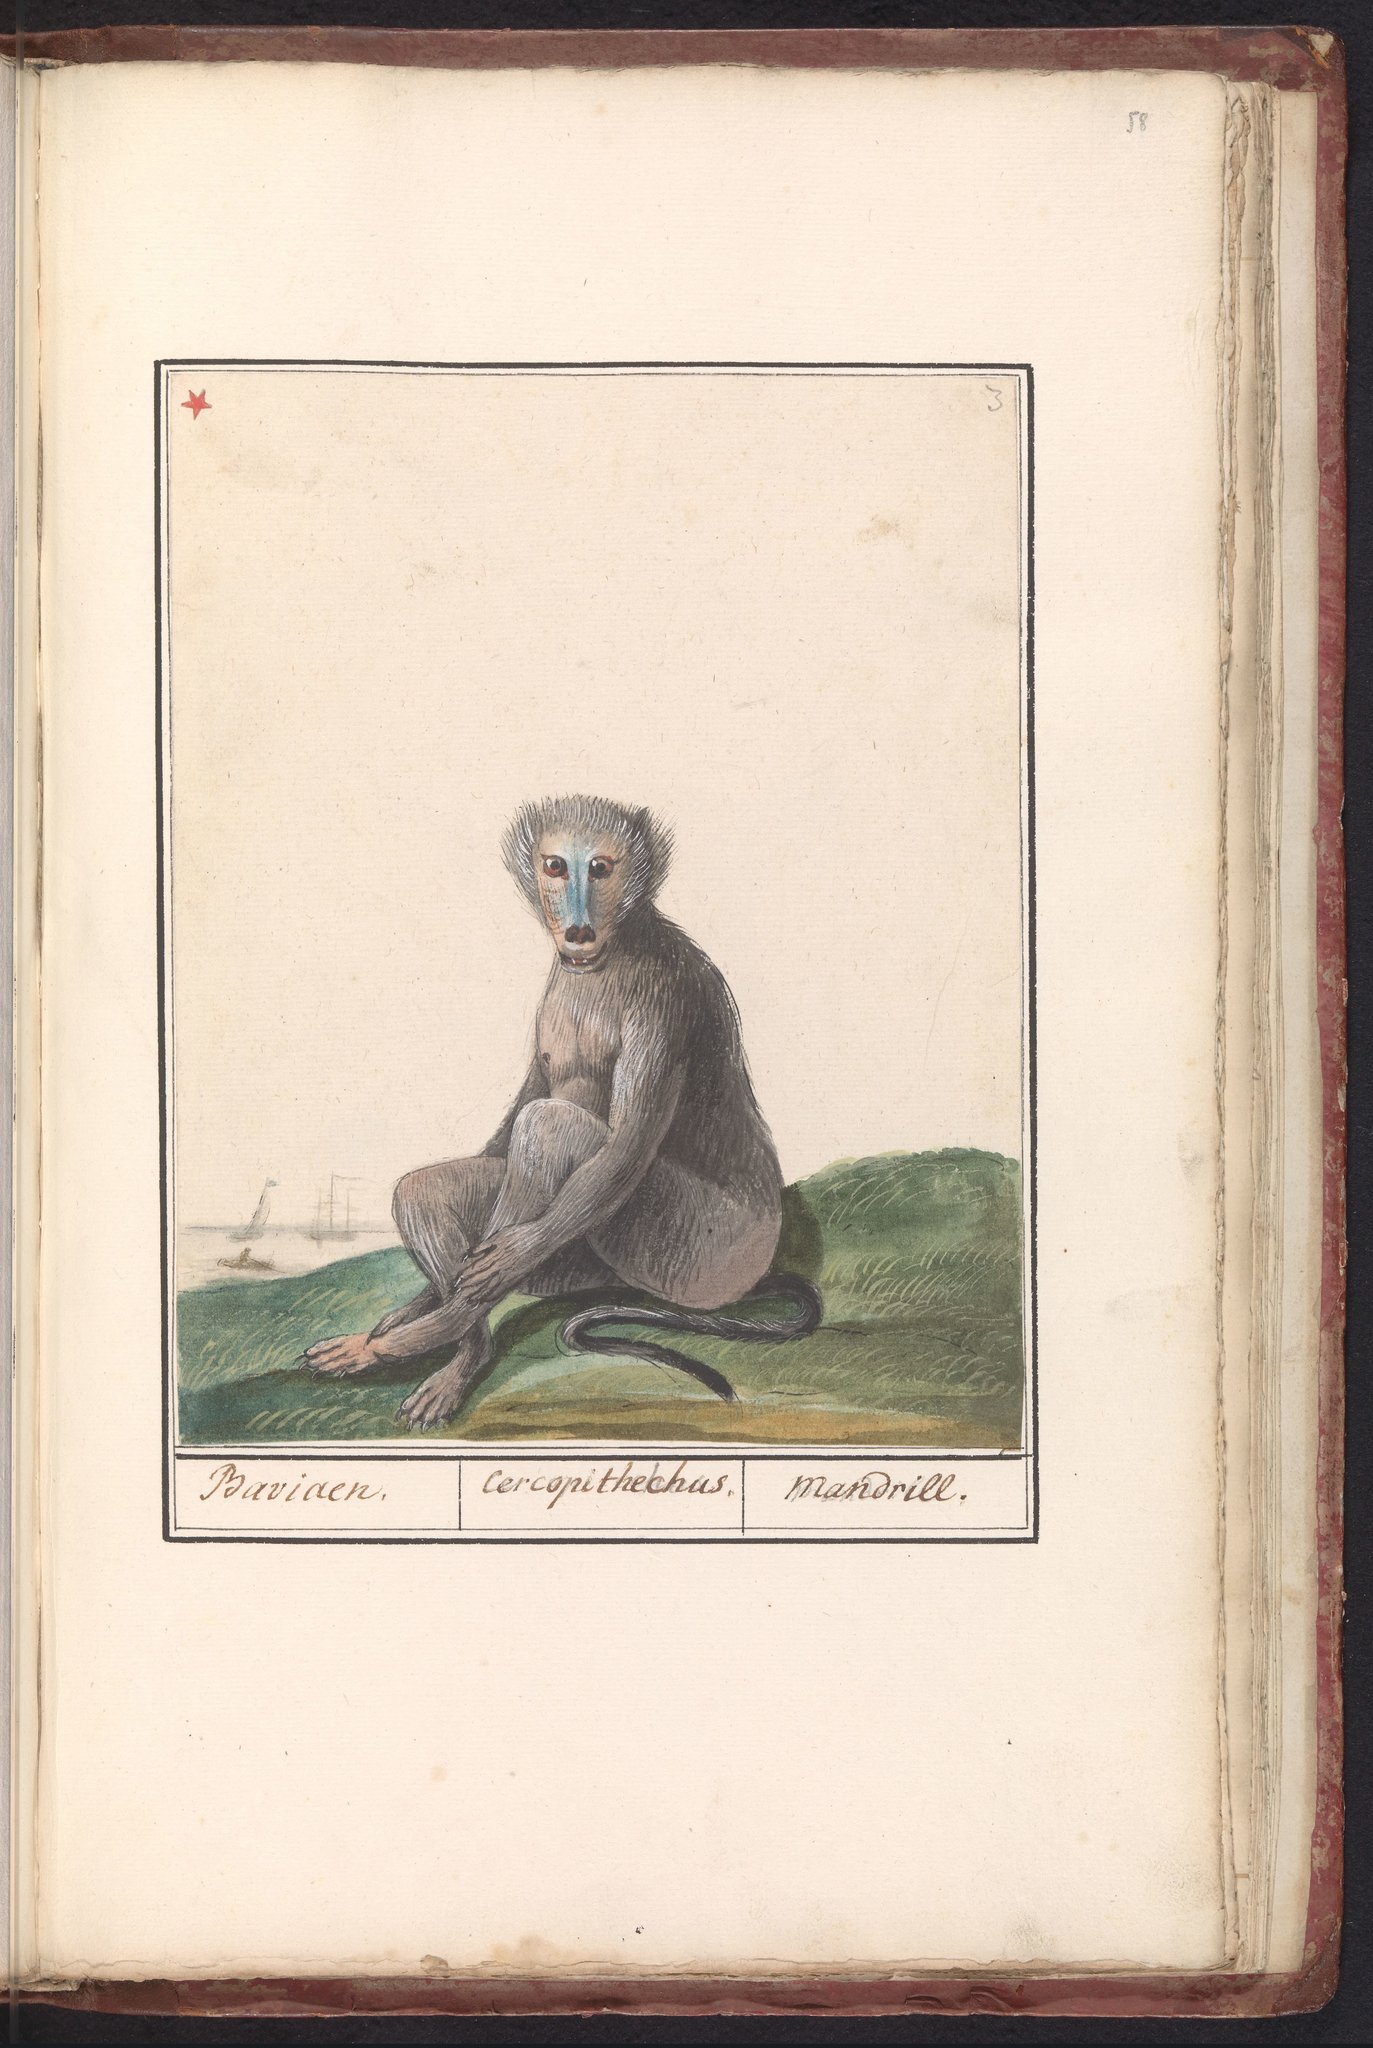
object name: drawing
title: Baviaen. / Cercopithechus. / Mandrill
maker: Anonymous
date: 1790-1814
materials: paint, ink, paper, pencil, watercolor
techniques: brush, pen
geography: southern netherlands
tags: monkeys, apes: mandril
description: Mandil. Genummerd rechtsboven: 3. Linksboven gemerkt met een rood sterretje. Onderdeel van het tweede album met tekeningen van viervoeters. Tweede van twaalf albums met tekeningen van dieren, vogels en planten bekend rond 1600, gemaakt in opdracht van keizer Rudolf II. Met toelichting in Nederlands, Latijn en Frans.